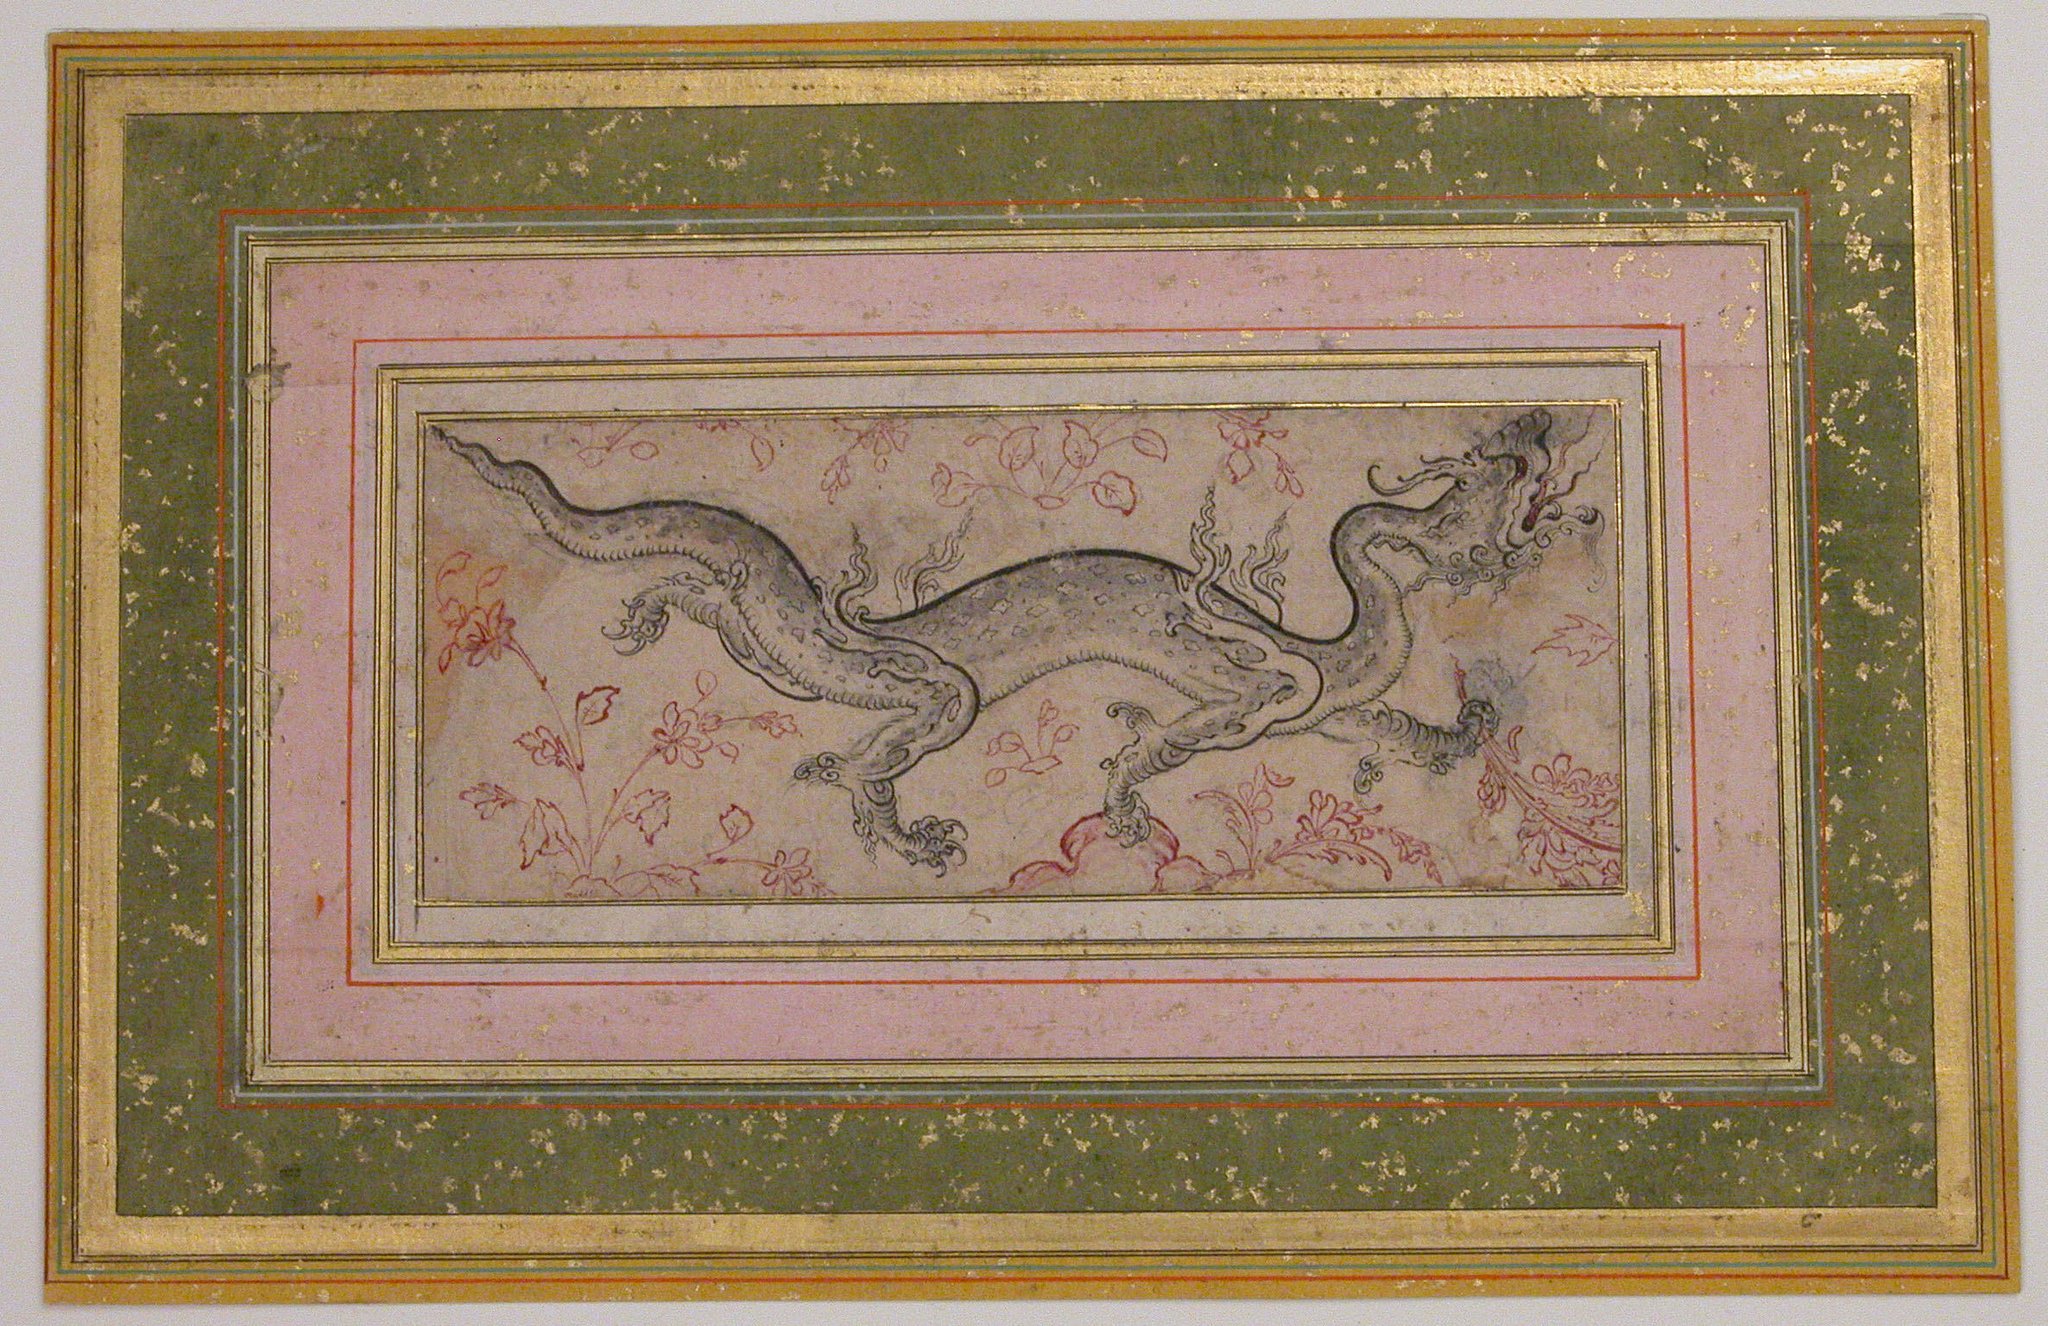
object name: illustrated single work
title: Dragon in a Landscape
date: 1501-1600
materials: ink, paper, watercolor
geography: turkey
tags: dragons,landscapes